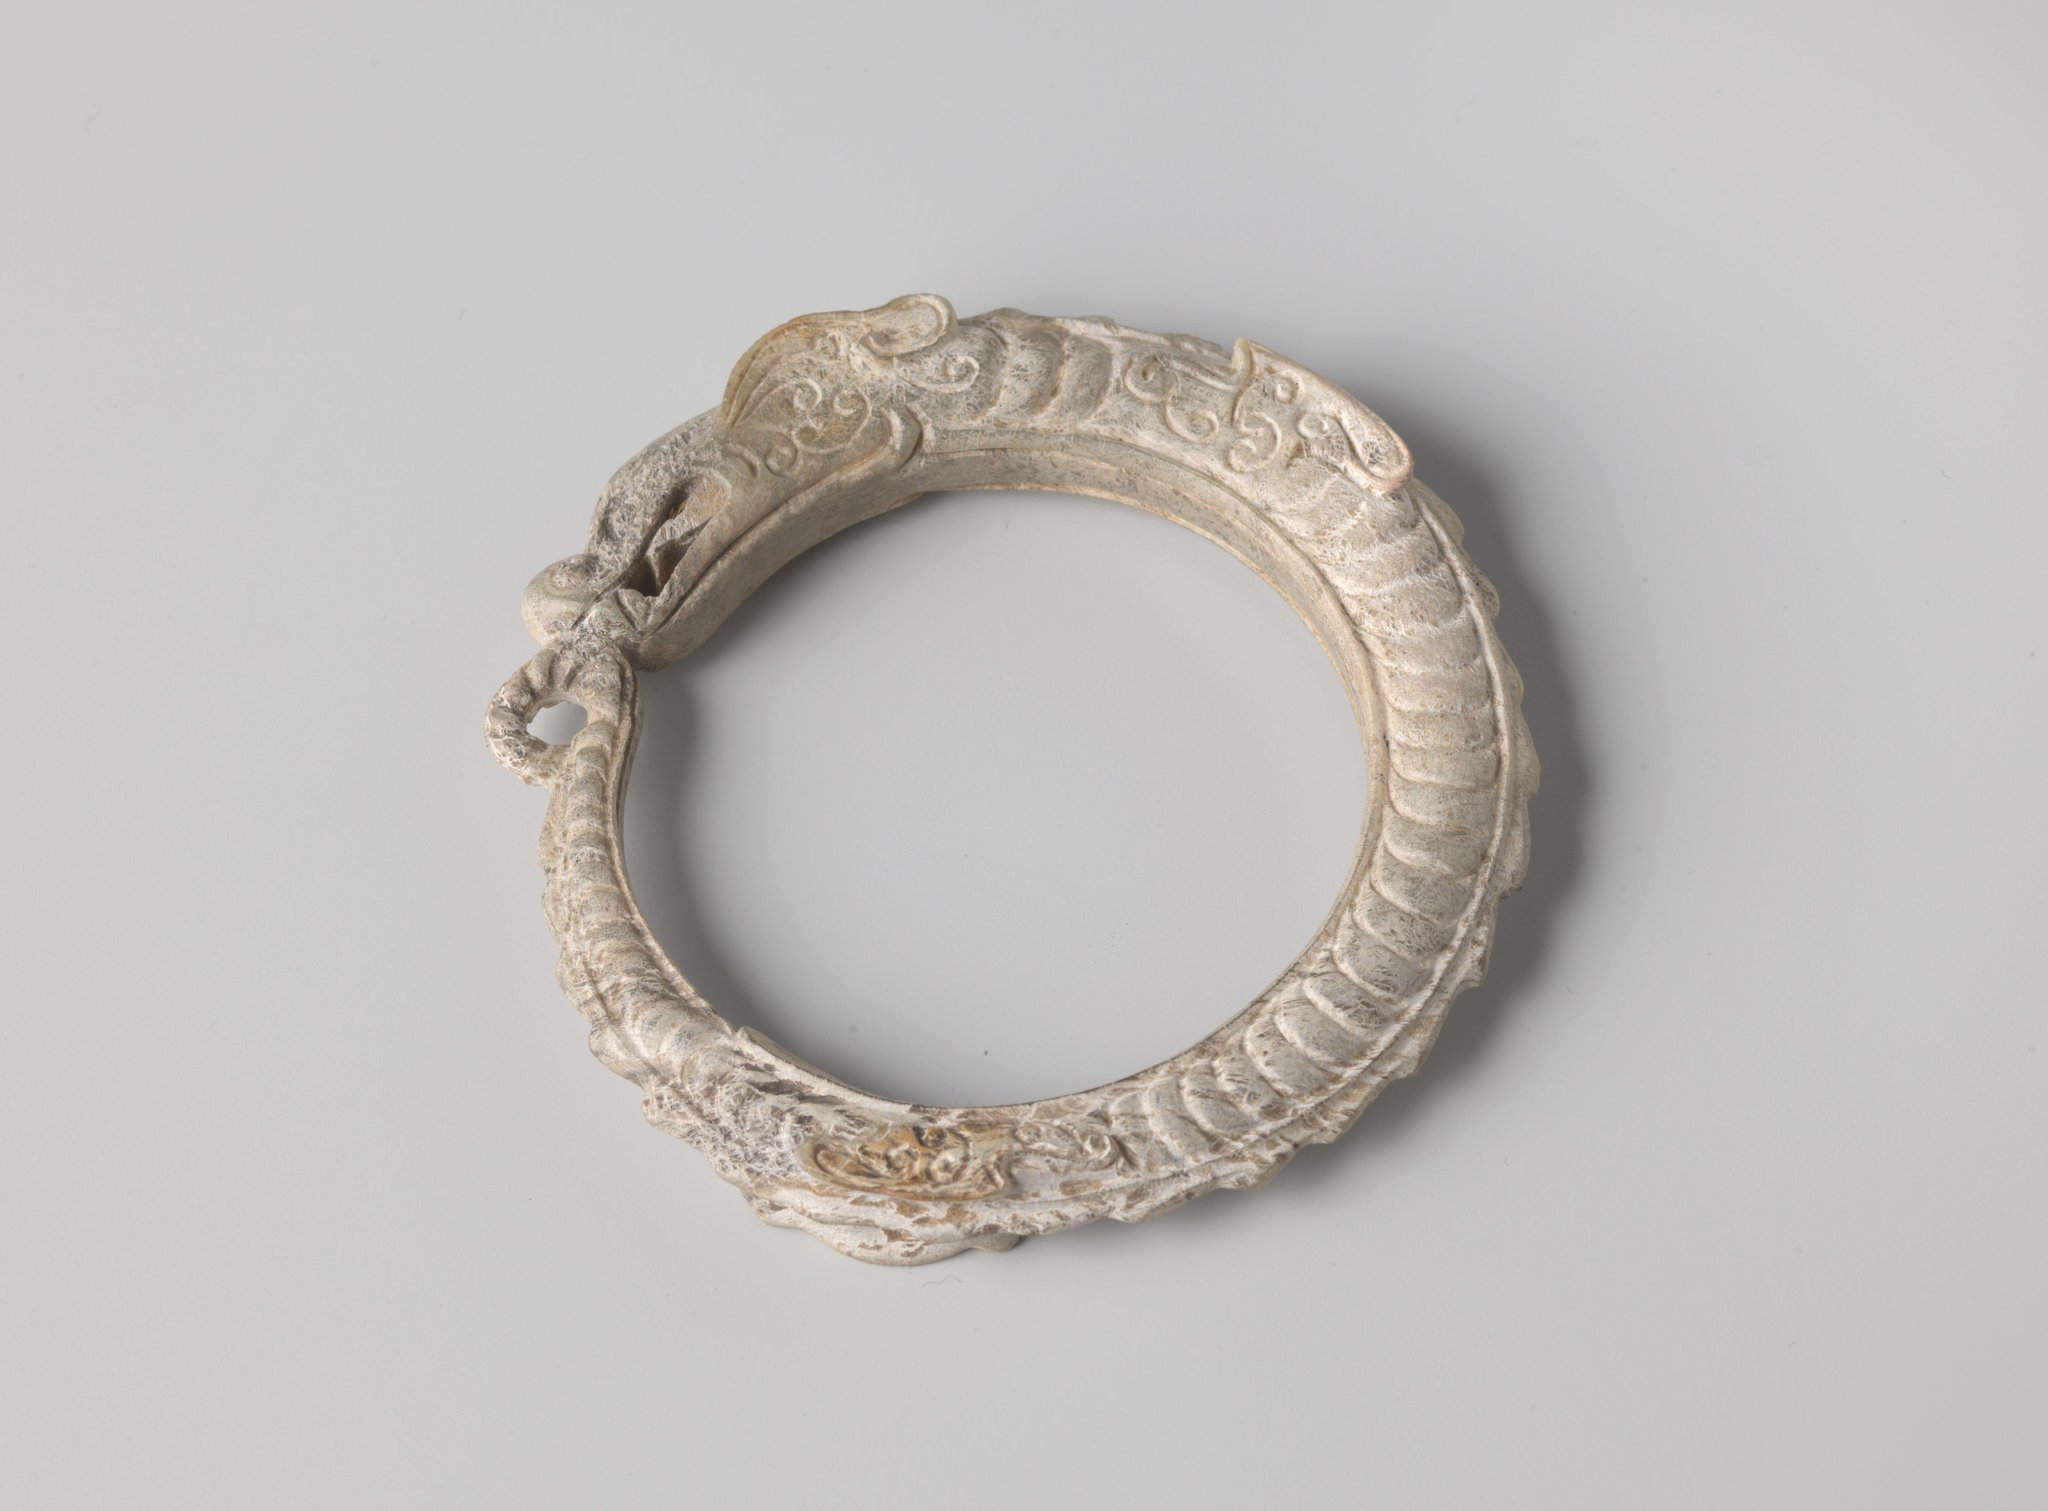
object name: ring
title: Ring in de vorm van een draak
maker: Anonymous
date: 1100-1300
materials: jade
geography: china